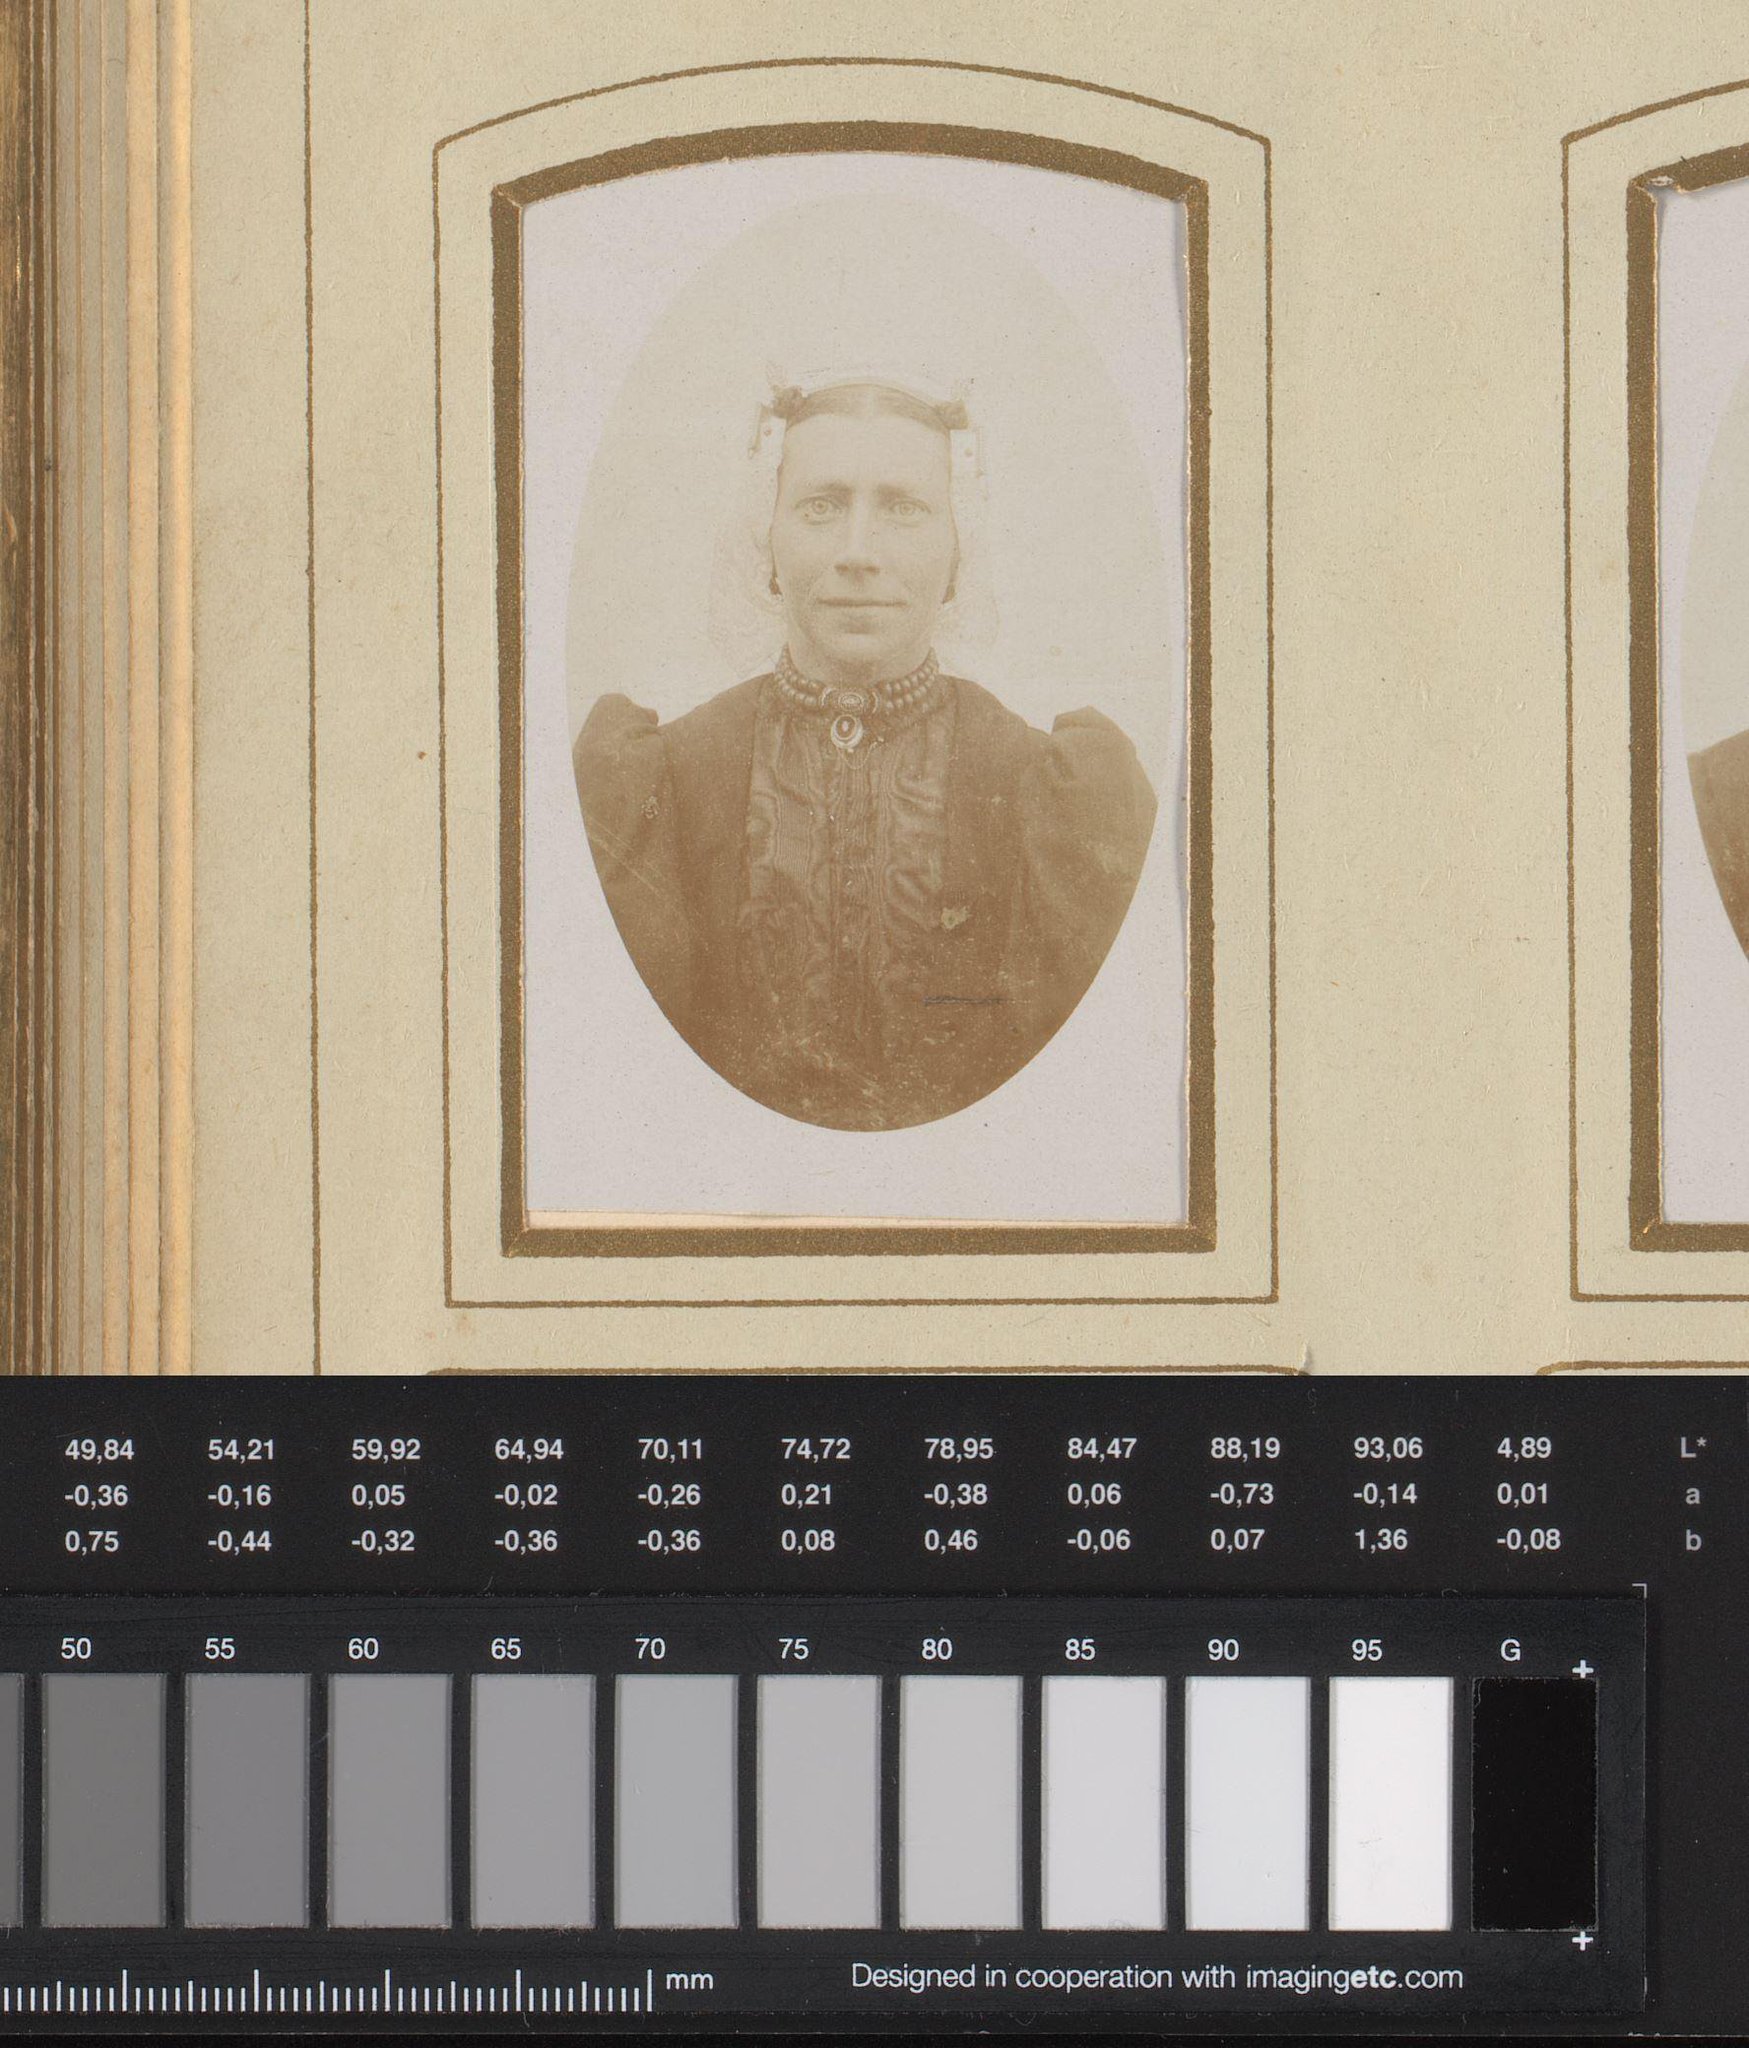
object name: album leaf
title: Portret van een vrouw met witte klederdrachtmuts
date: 1890-1910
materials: cardboard, photographic support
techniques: collodion silver print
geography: amsterdam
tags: historical persons - bb - woman, head-gear: cap, folk costume, regional costume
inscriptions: inscription: ‘D. Fraenkel & Zoon/ PHOTOGRAPHEN/ Amsterdam 43.Commelinstraat 43./ Specialiteit in vergrootingen van deze Portretten/ kunnen steeds nabesteld worden.’